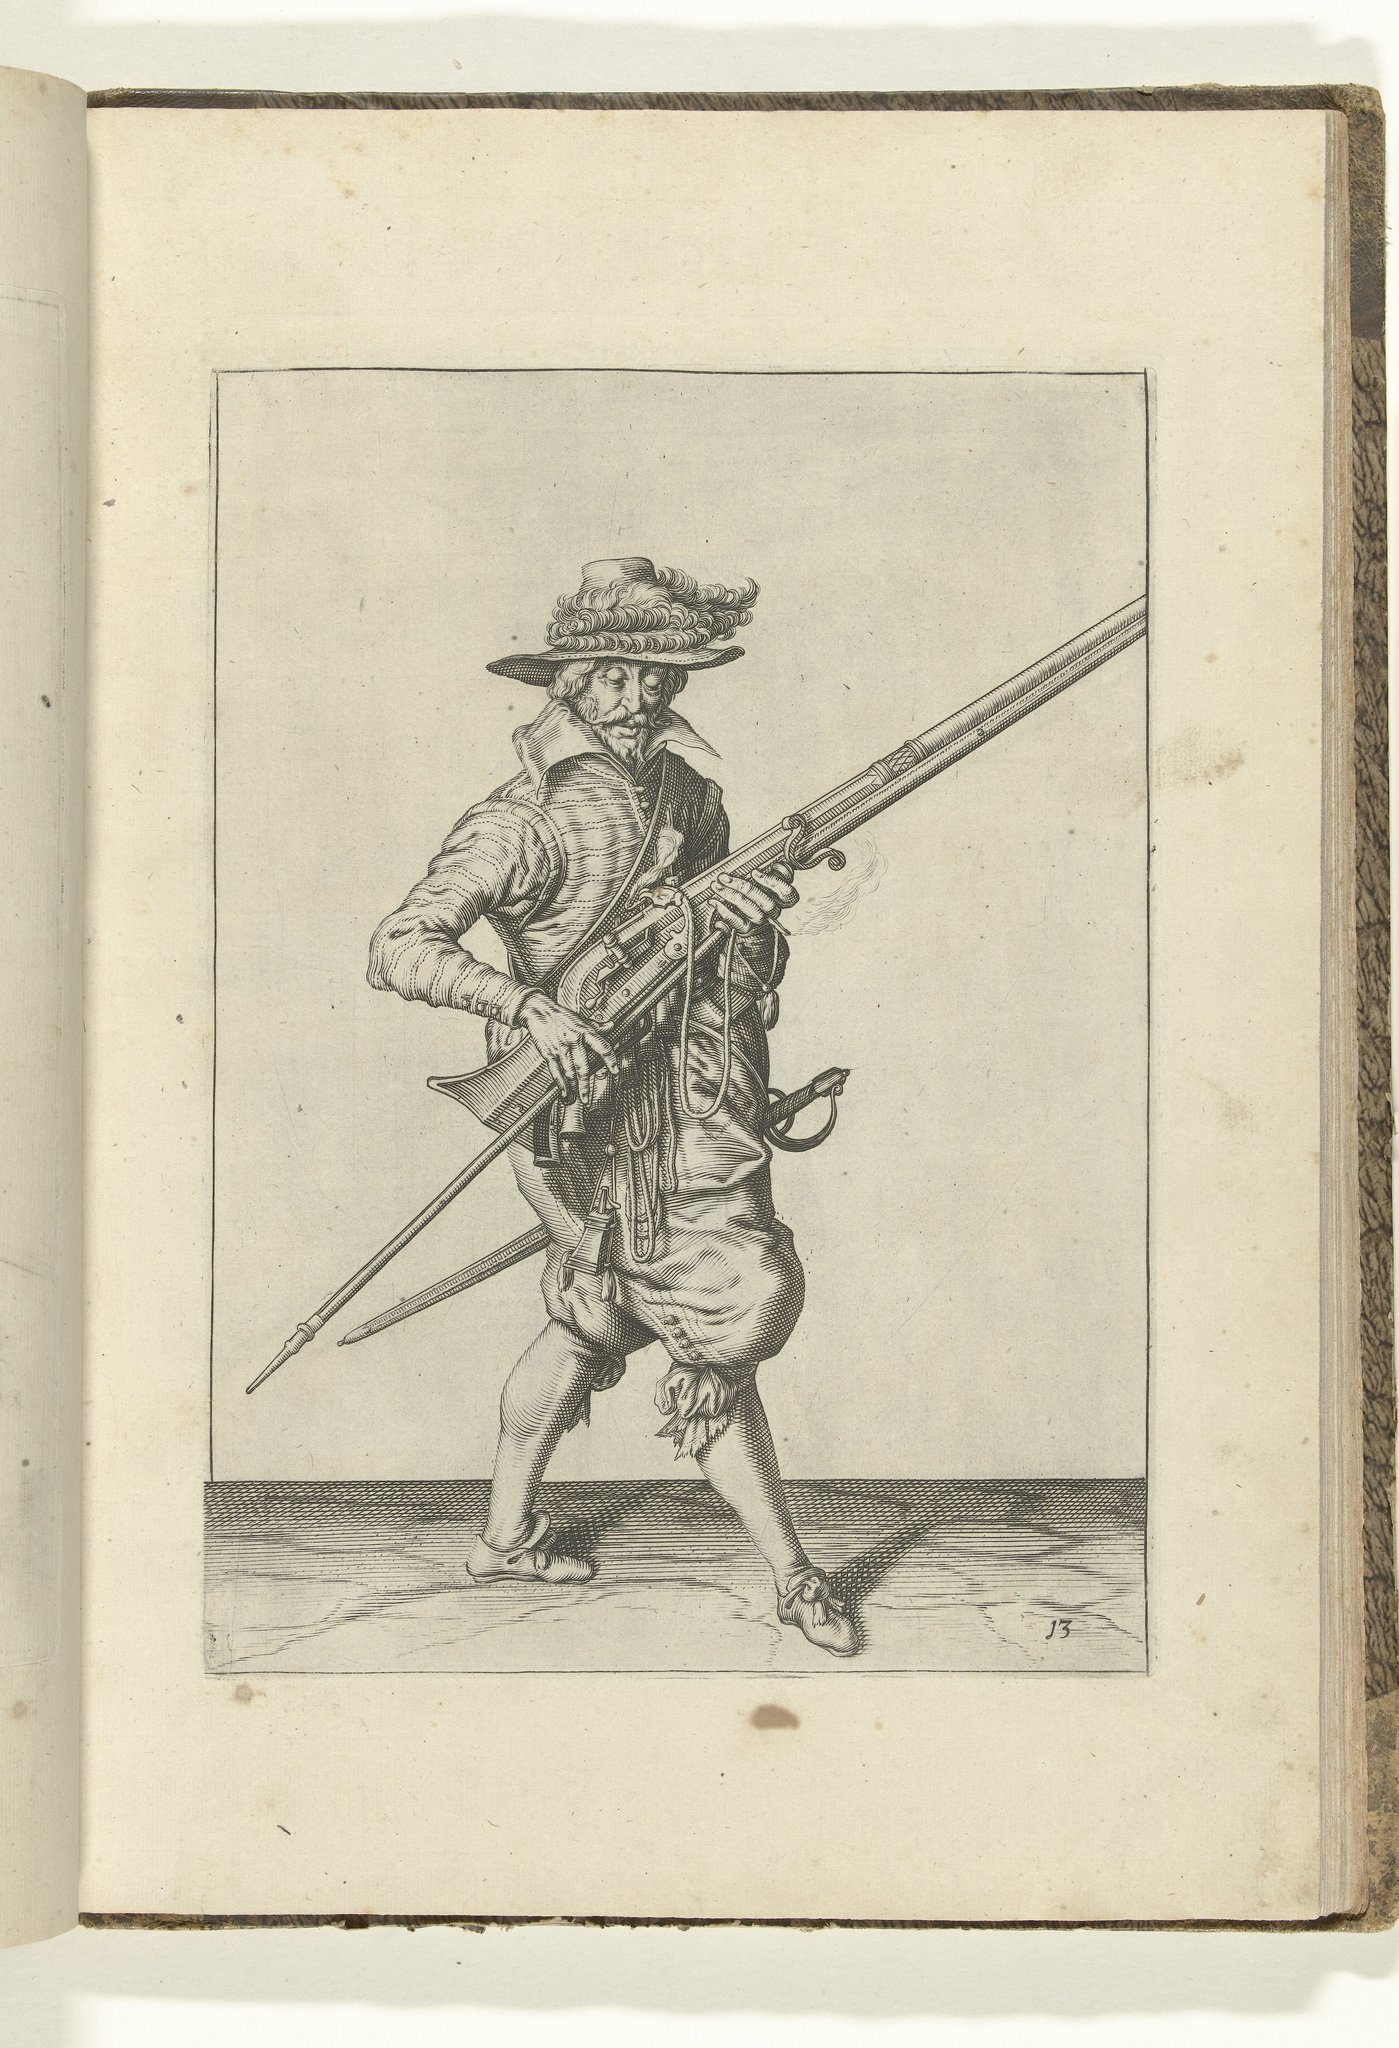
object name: print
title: Soldaat die zijn musket met zijn linkerhand schuin omhoog gericht vasthoudt, terwijl hij zijn furket onder de loop vandaan trekt (nr. 13), ca. 1600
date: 1597-1608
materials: paper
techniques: engraving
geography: amsterdam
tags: the hague, maurice (prince of orange), handling of weapons ~ military training, weapons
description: Een soldaat, ten voeten uit, naar rechts, die een musket (een bepaald type vuurwapen) met zijn linkerhand vasthoudt, nadat hij gevuurd heeft, de loop schuin omhoog gericht om te voorkomen dat hij ongewild een gezel verwondt (nr. 13), ca. 1600. In zijn linkerhand behalve het roer ook een brandende lont. Met zijn rechterhand trekt hij het furket (de musketvork) onder de loop vandaan. Plaat 13 in de instructies voor het hanteren van het musket: Brief enseignement, sur les pourtraitz figurez, touchant le droit maniement du Mousquet. Onderdeel van de illustraties in een Franse editie van J. de Gheyns Wapenhandelinghe: J. de Gheyn, Maniement d'armes, d'arquebuses, mousquetz et piques : en conformité de l'ordre de Mour le Prince Maurice, Prince d'Orange, Amsterdam 1608. Krijgswezen rond 1600.